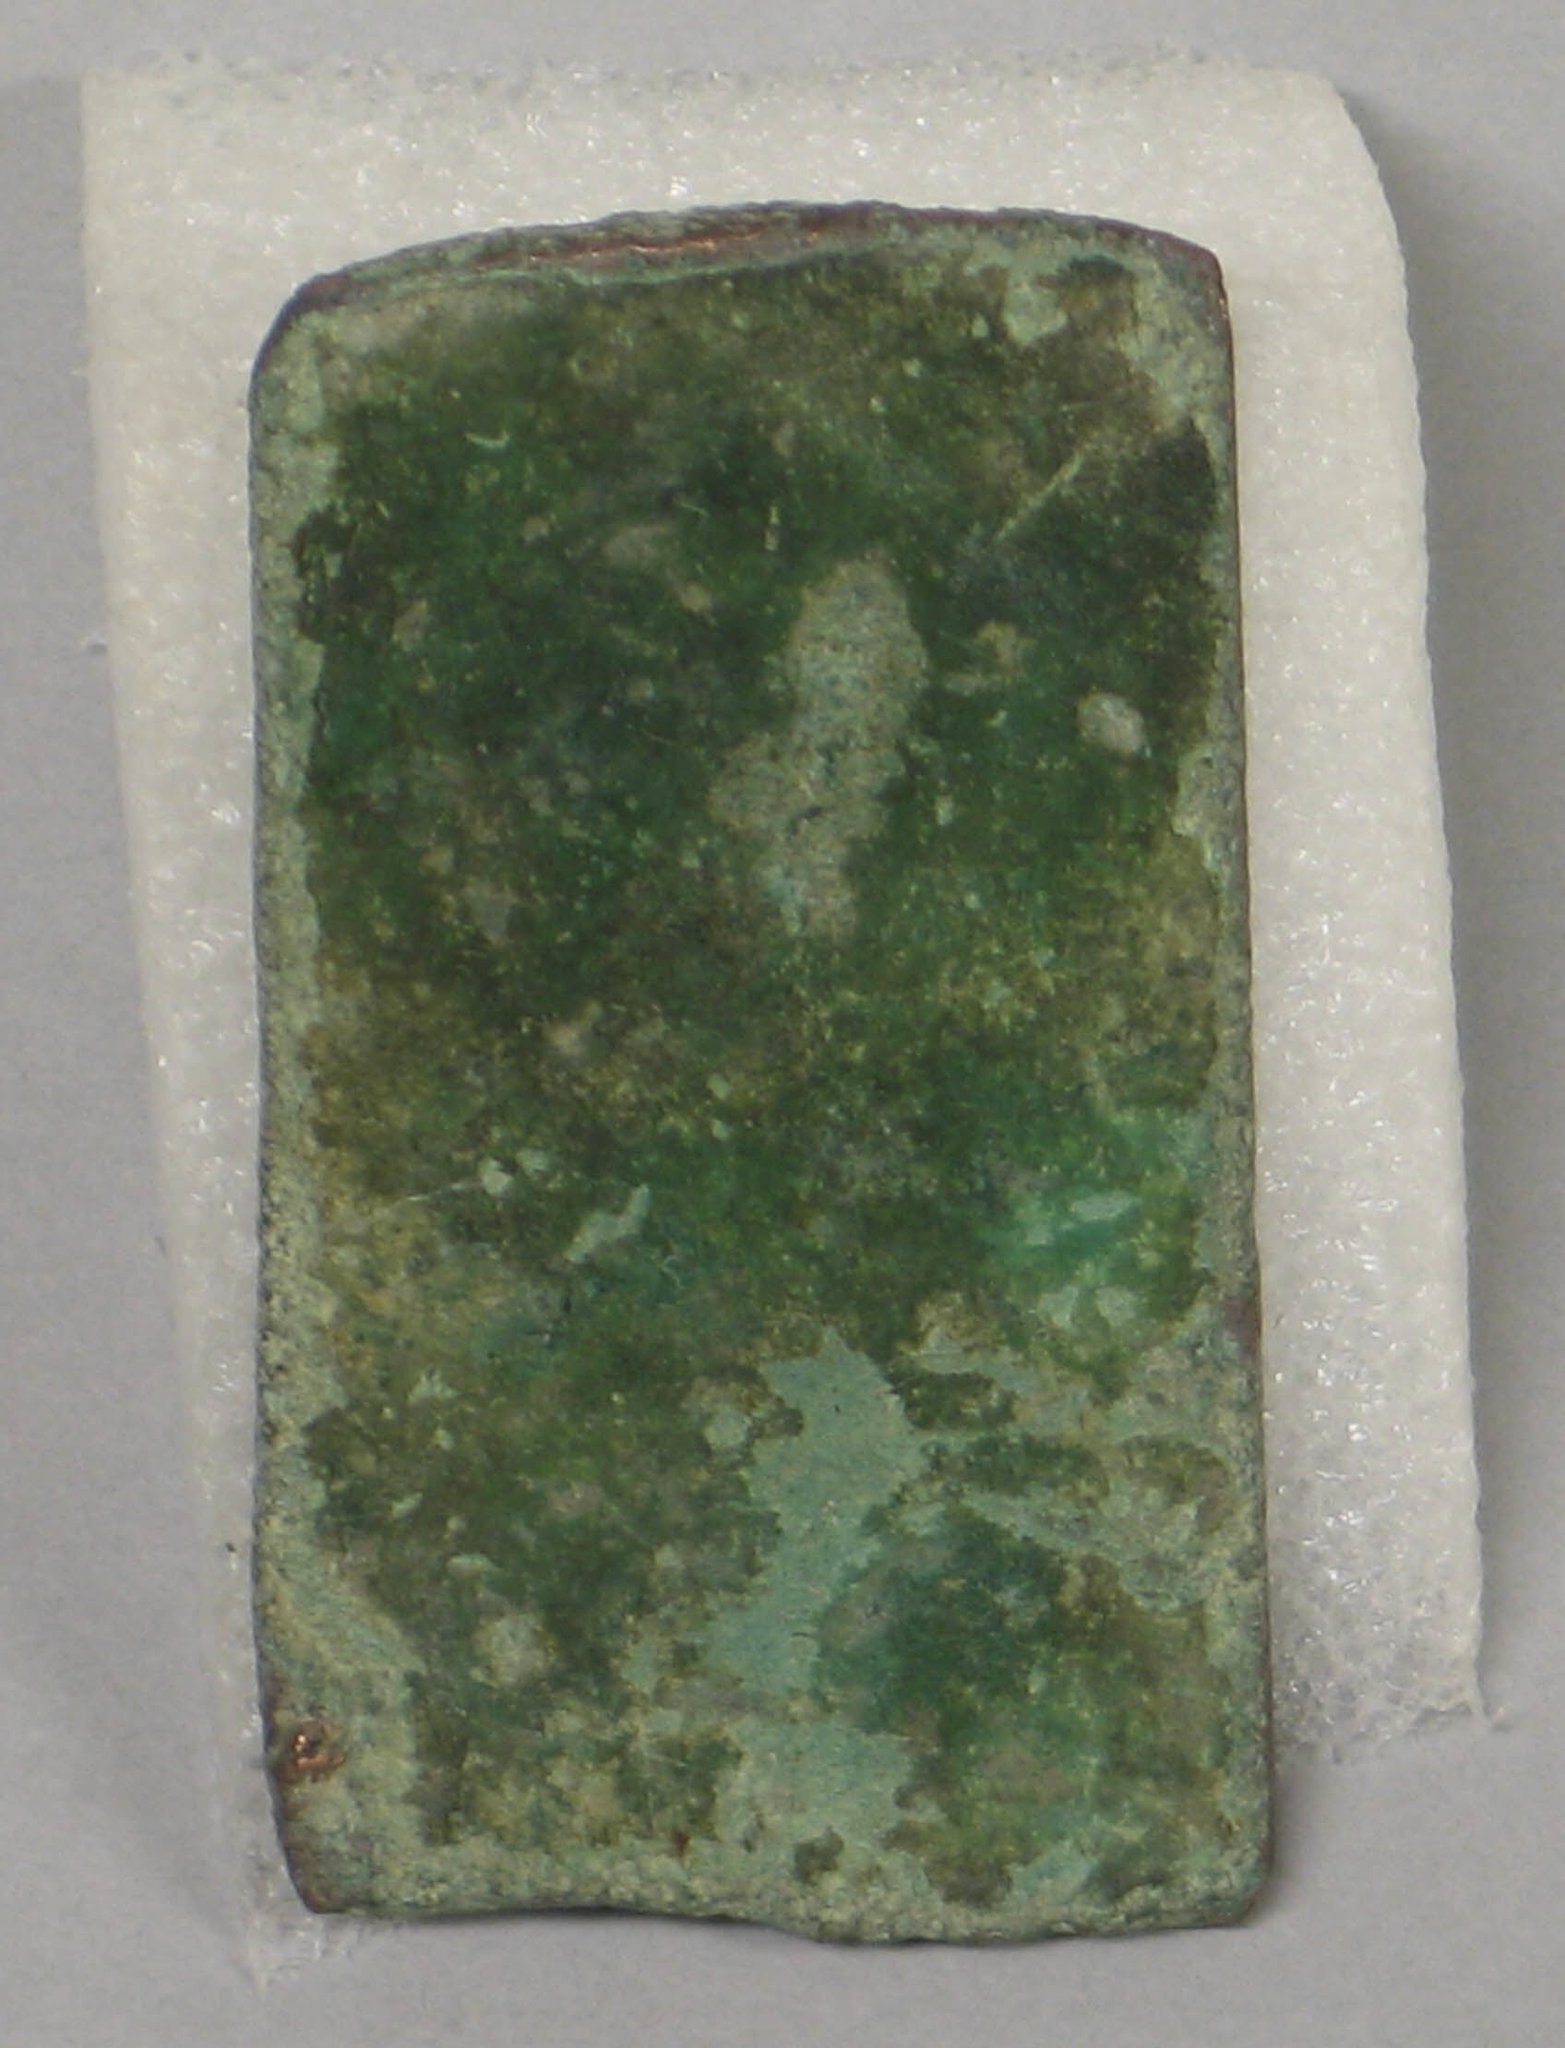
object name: ax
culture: indian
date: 1500-500 BCE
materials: copper